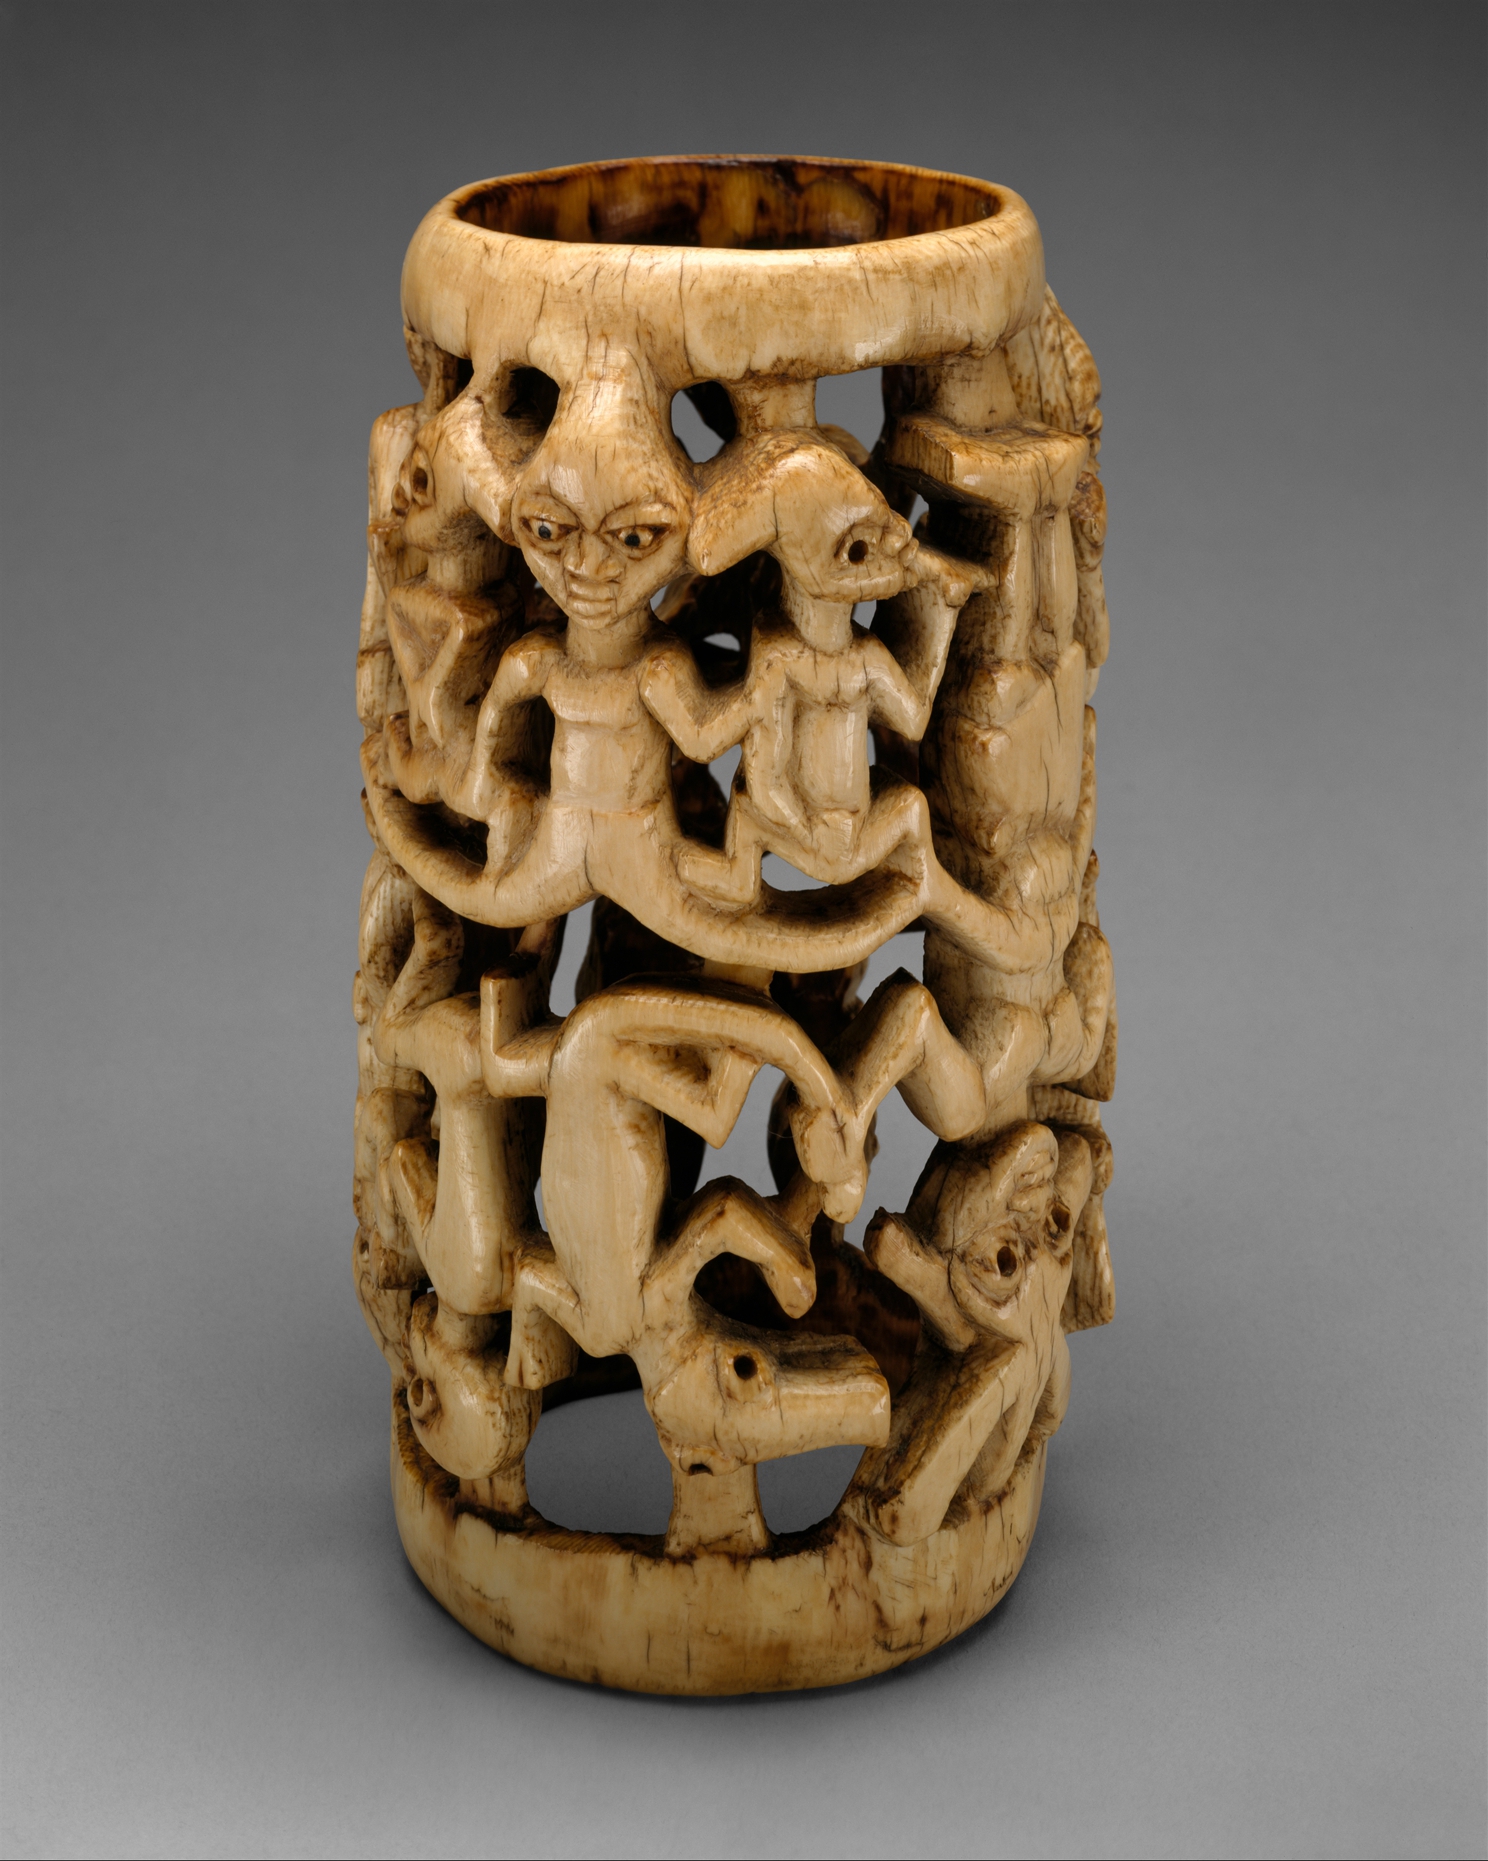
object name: bracelet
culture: yoruba peoples, owo group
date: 1601-1900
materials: plant material, ivory, wood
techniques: inlay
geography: nigeria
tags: human figures,crocodiles